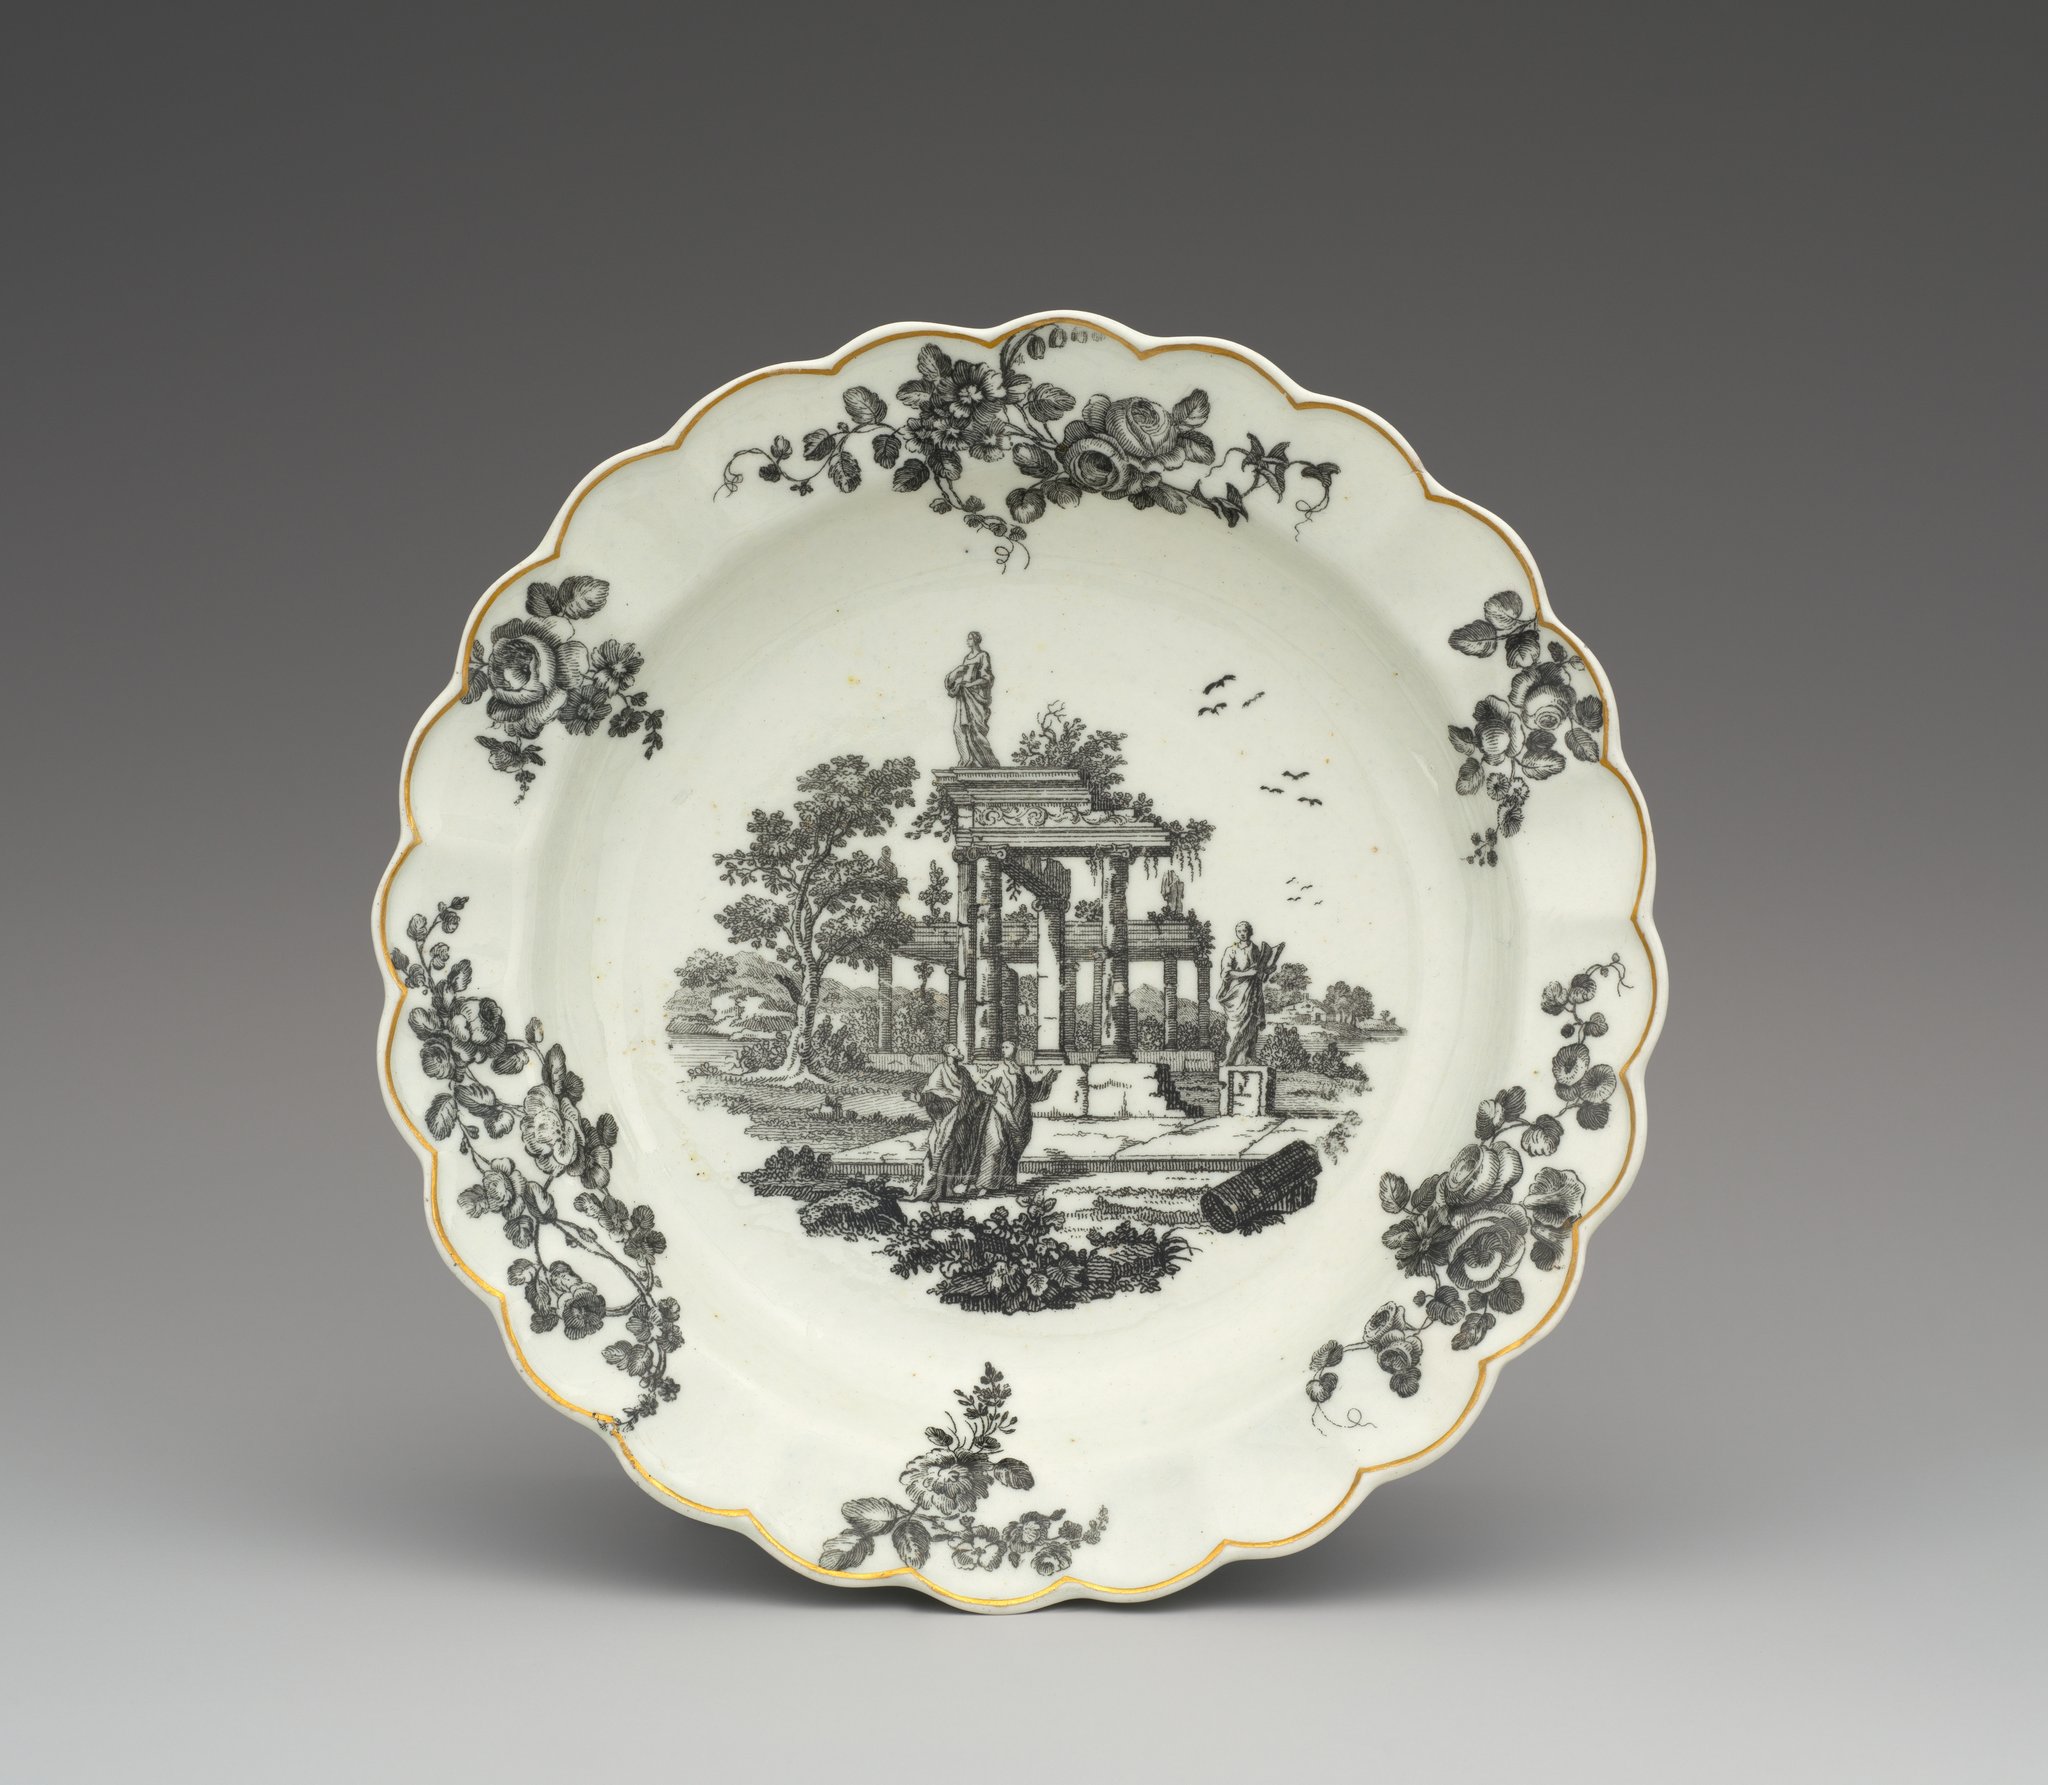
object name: plate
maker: worcester factory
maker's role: factory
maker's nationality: british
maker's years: 1751-2008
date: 1770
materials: soft paste porcelain